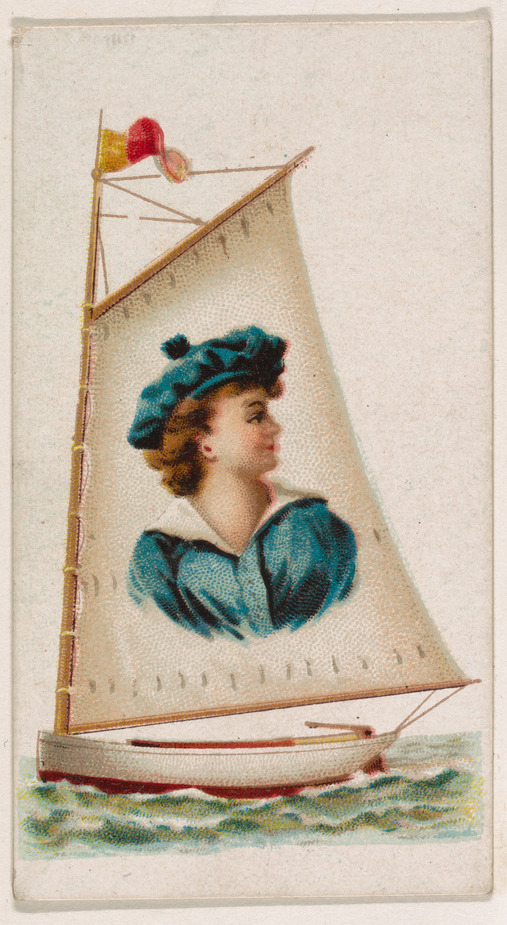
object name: print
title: Sailboat, from the Novelties series (N228, Type 5) issued by Kinney Bros.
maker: kinney brothers tobacco company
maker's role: publisher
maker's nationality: american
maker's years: 1869-2011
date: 1889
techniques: color lithograph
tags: women,boats